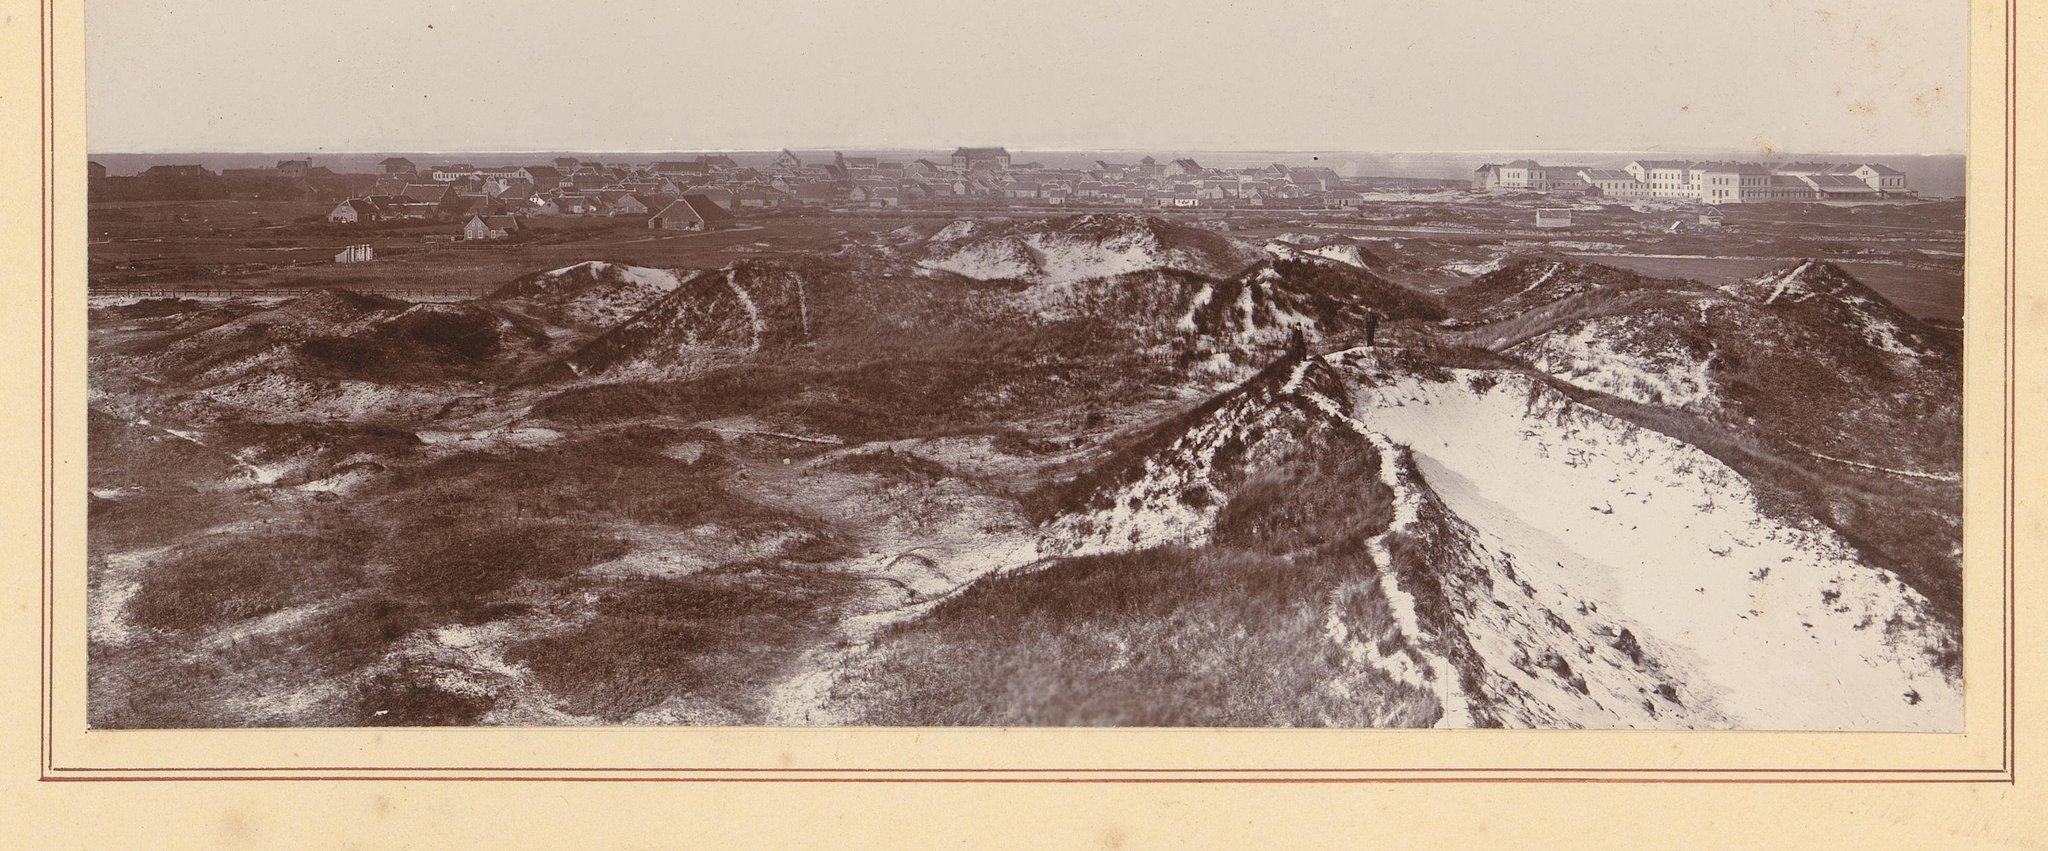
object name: photograph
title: Duinen en dorp op Norderney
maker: Anonymous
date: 1870-1875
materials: paper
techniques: gelatin silver print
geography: norderney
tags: prospect of village, silhouette of village, dunes (sea not visible); in the dunes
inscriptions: inscription: ‘Ist am Schemel seiner Füsse/ Und am Thron schon solcher Schein/ O was wird für Freud und Wo[...]/ An dem Herzen GOTTES sein!’